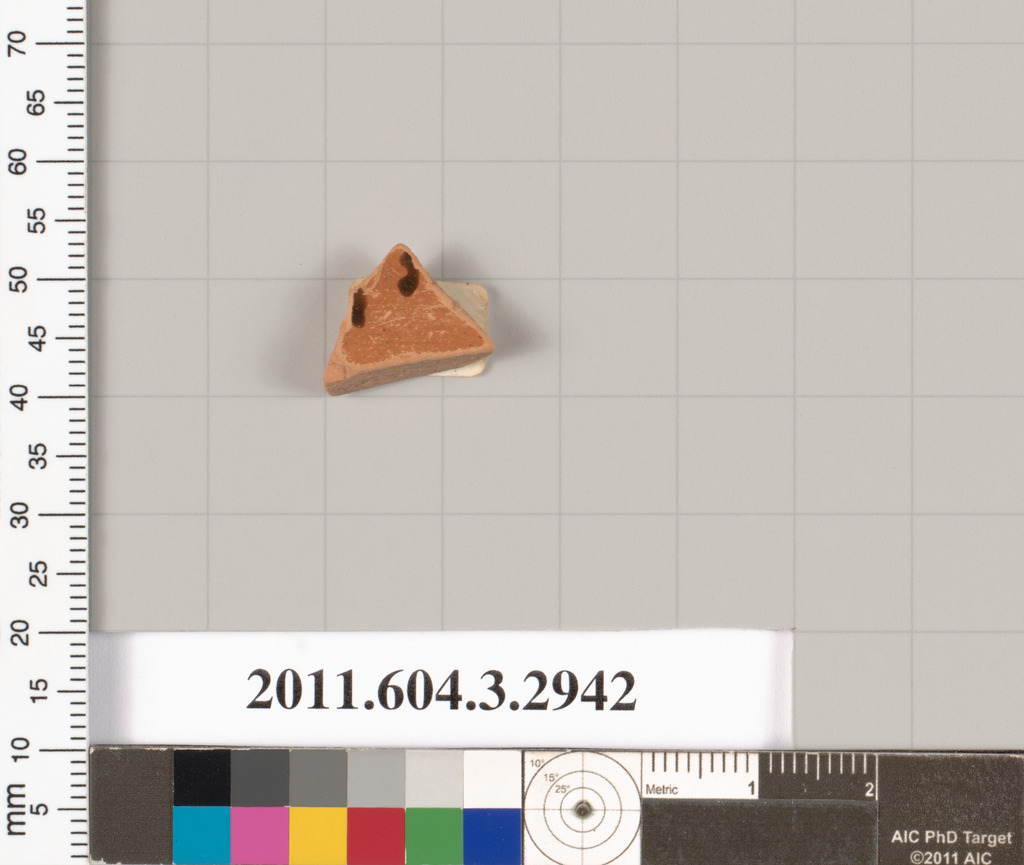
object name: kylix fragment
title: Terracotta fragment of a kylix (drinking cup)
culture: greek, attic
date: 550-501 BCE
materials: terracotta